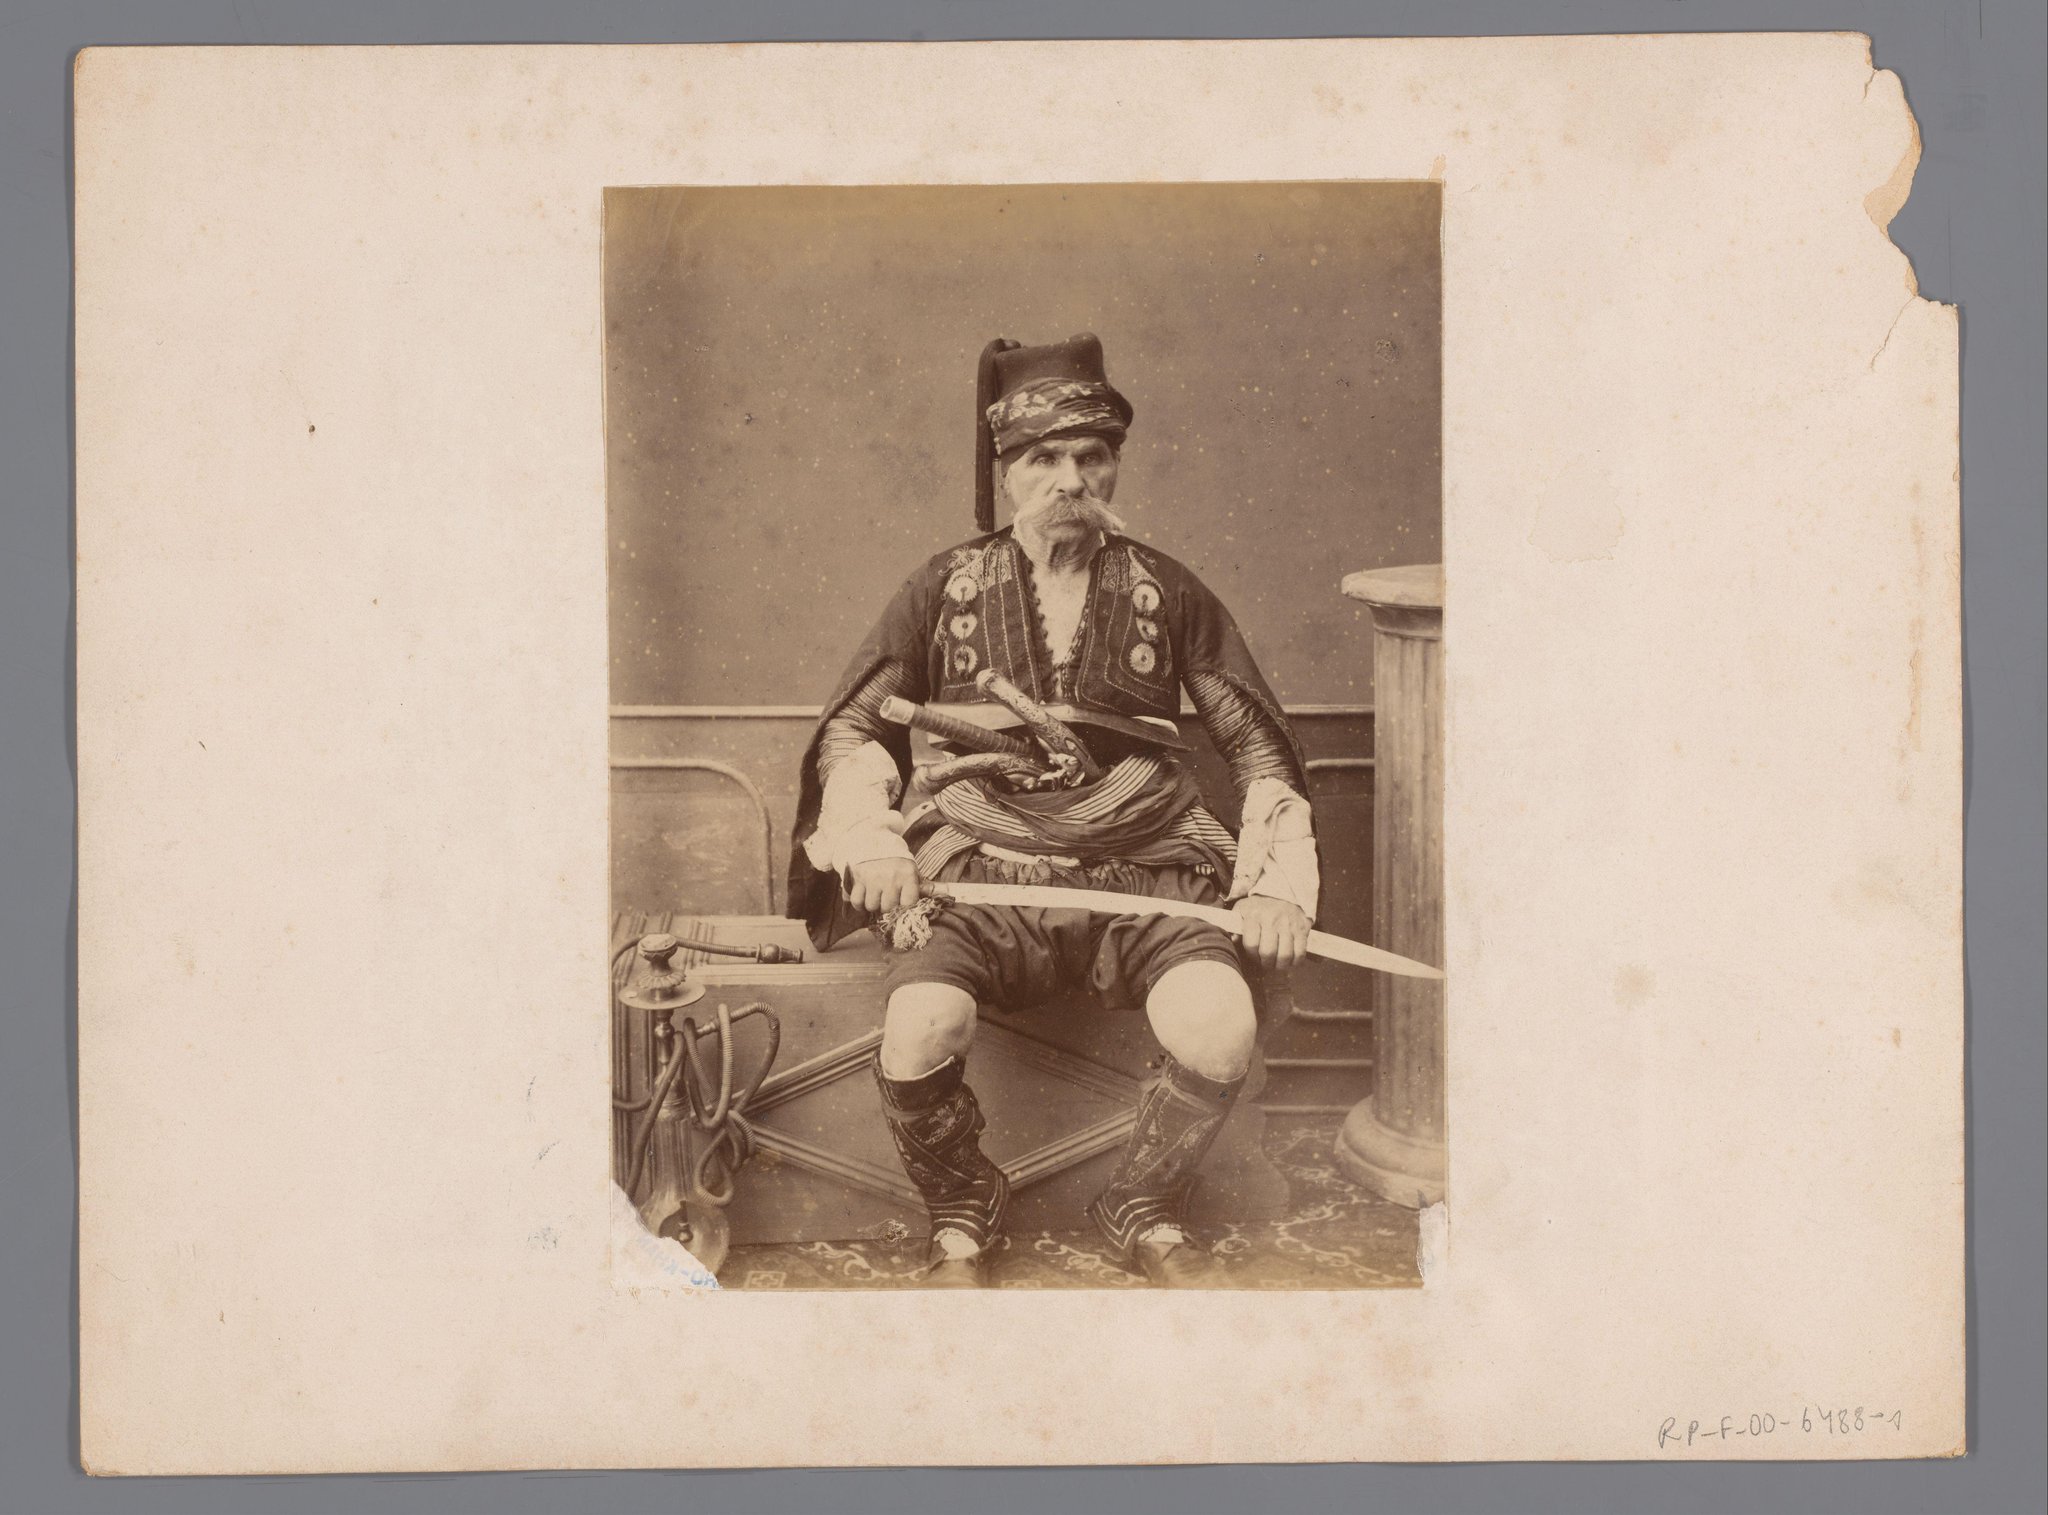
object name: photograph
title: Portret van oude man in klederdracht/derwisj [?]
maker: Anonymous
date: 1880-1900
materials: cardboard, photographic support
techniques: albumen print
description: Portret van oude man in klederdracht/derwisj [?].